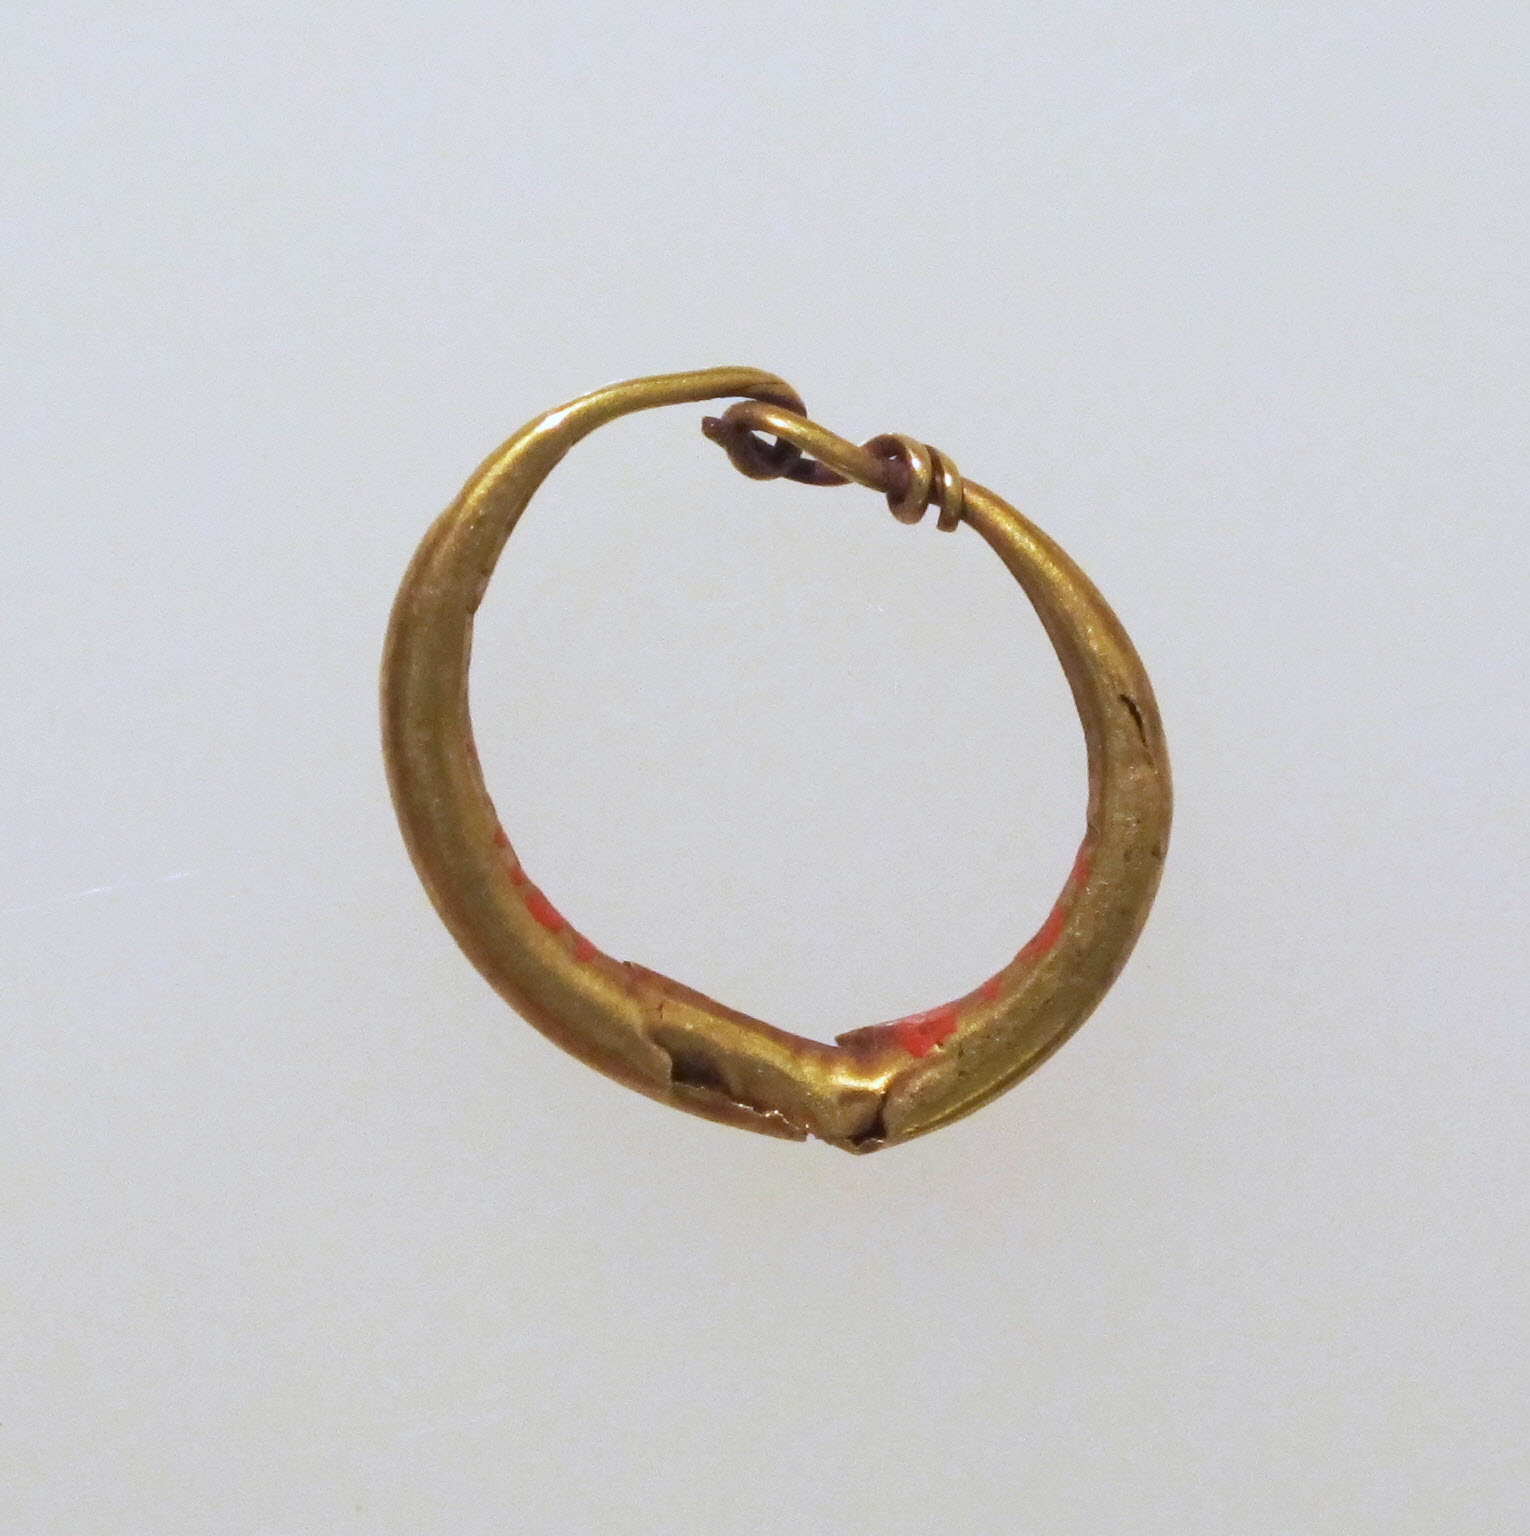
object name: earring loop type, plain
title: Earring-loop type, plain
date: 7000 BCE-330 CE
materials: gold